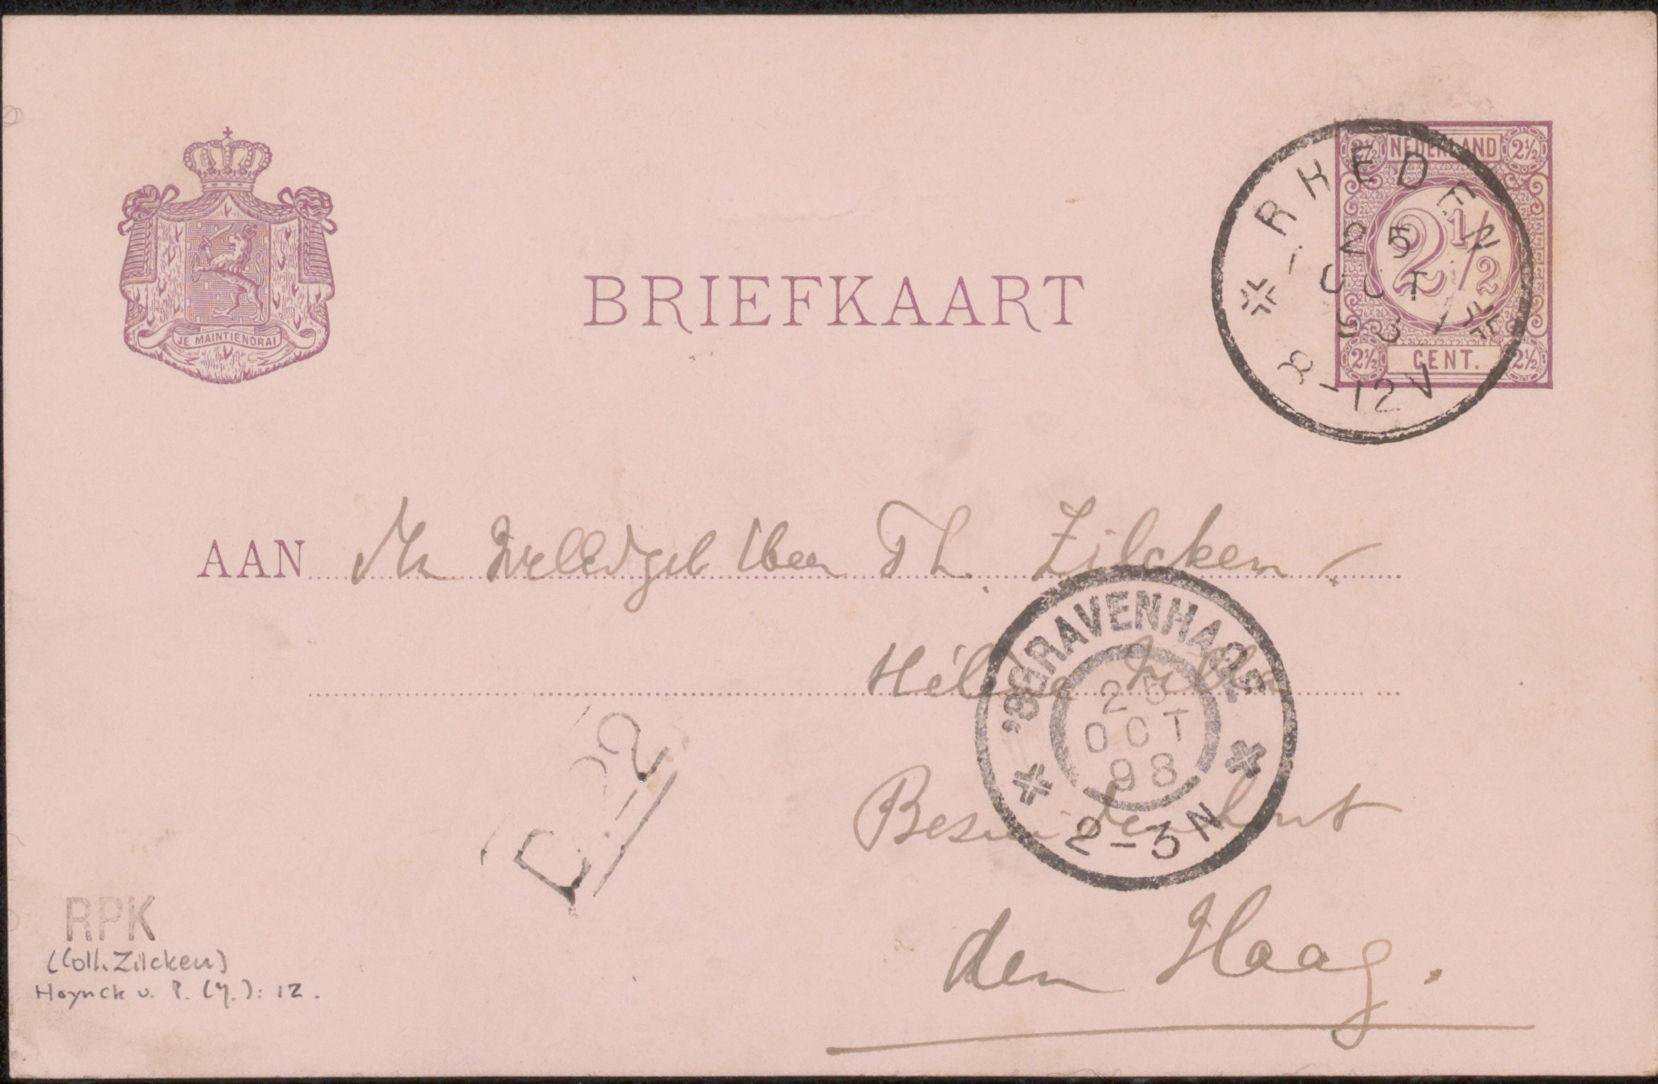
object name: postcard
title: Briefkaart aan Philip Zilcken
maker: jan hoynck van papendrecht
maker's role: draughtsman, painter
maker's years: 1858-1933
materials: cardboard, ink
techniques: pen, writing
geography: rheden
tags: rotterdam, herman robbers, the hague, painter, draughtsman, philip zilcken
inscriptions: collector's mark: ‘RPK’